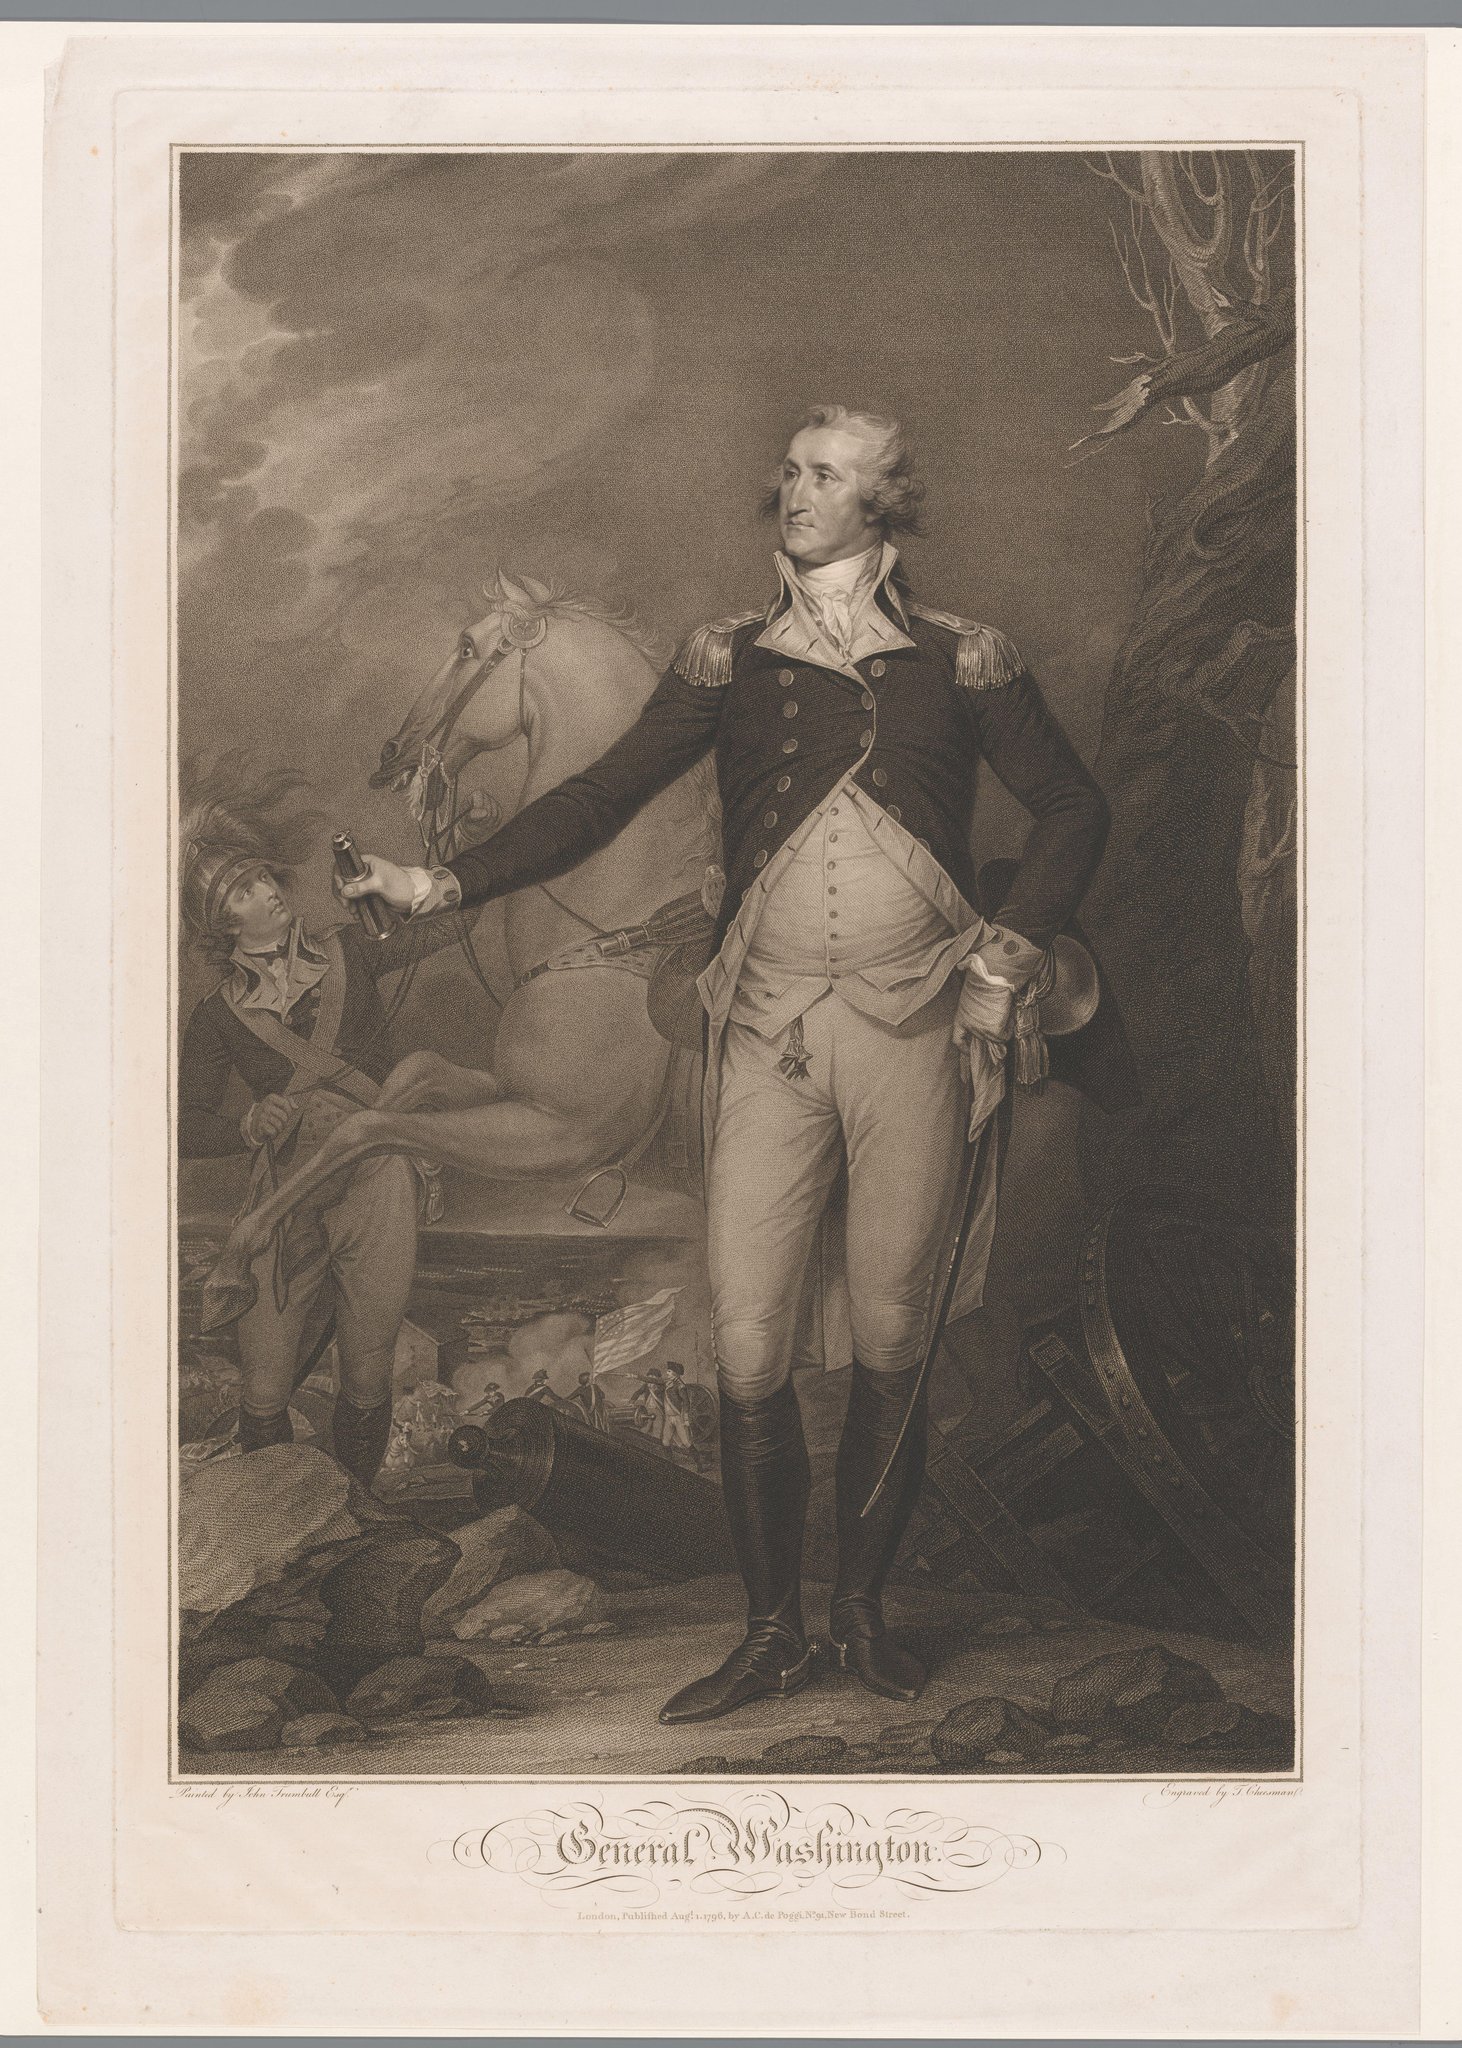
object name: print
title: Portret van George Washington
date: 1708-1796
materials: paper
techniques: engraving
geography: london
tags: president ~ head of republic, historical persons, battle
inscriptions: collector's mark: Lugt 2228